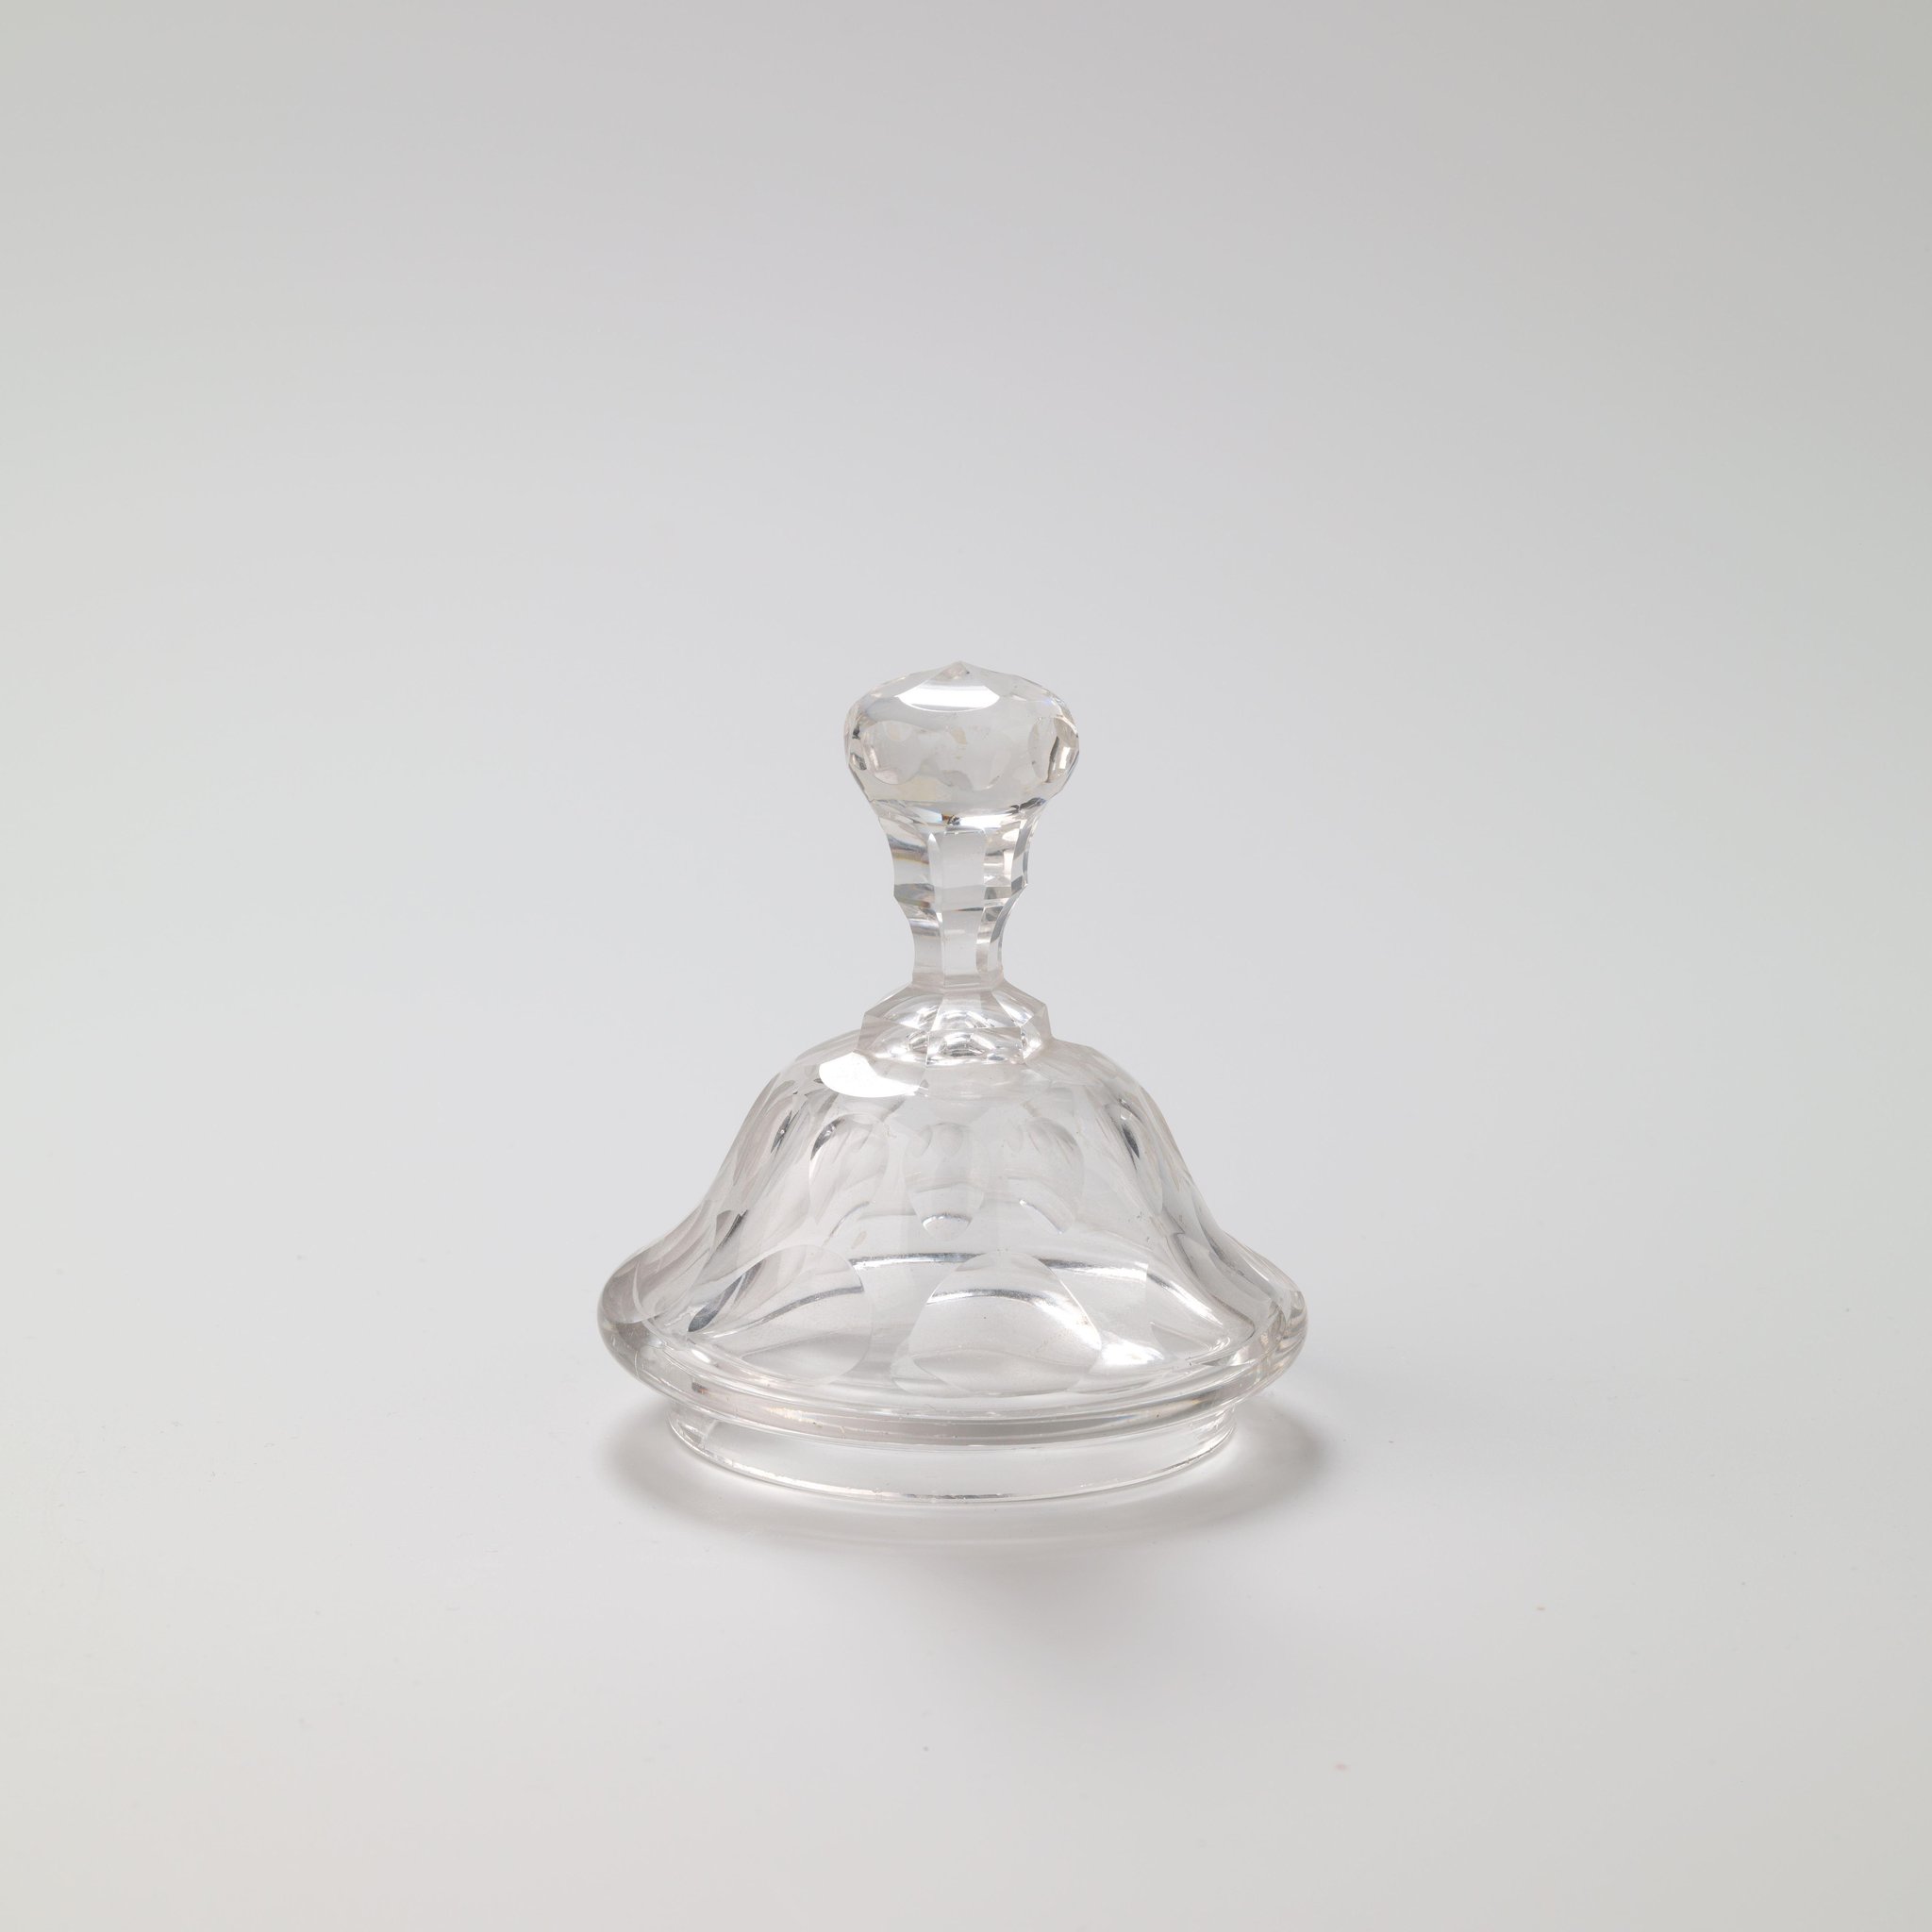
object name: sugar box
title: Deksel van suikerpot van geslepen kristal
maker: Anonymous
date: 1881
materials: crystal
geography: netherlands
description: Gewelfd deksel bekroond door een hoge knop. Behorend bij een suikerpot (BK-1981-12-B-1).